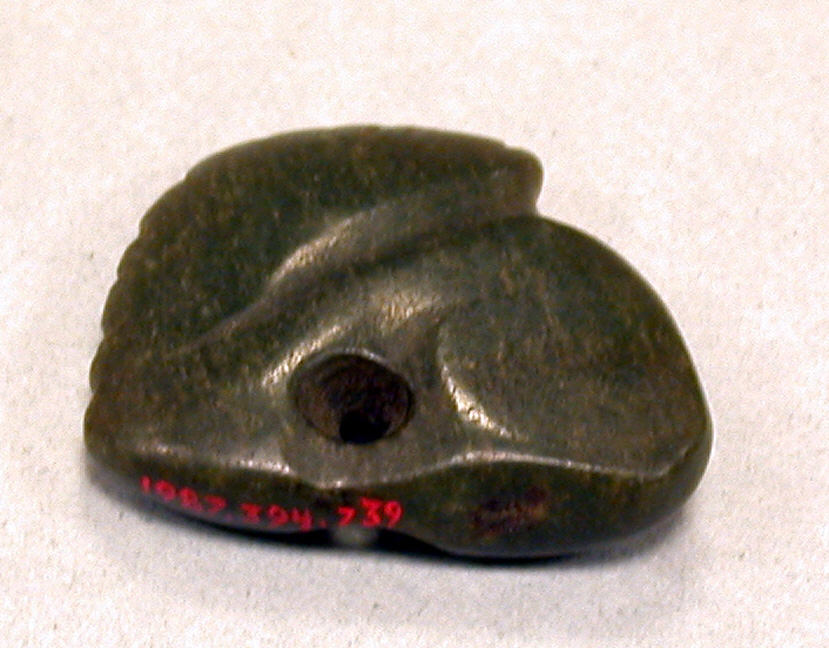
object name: pendant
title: Stone Pendant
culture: costa rican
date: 801-1500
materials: stone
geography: costa rica